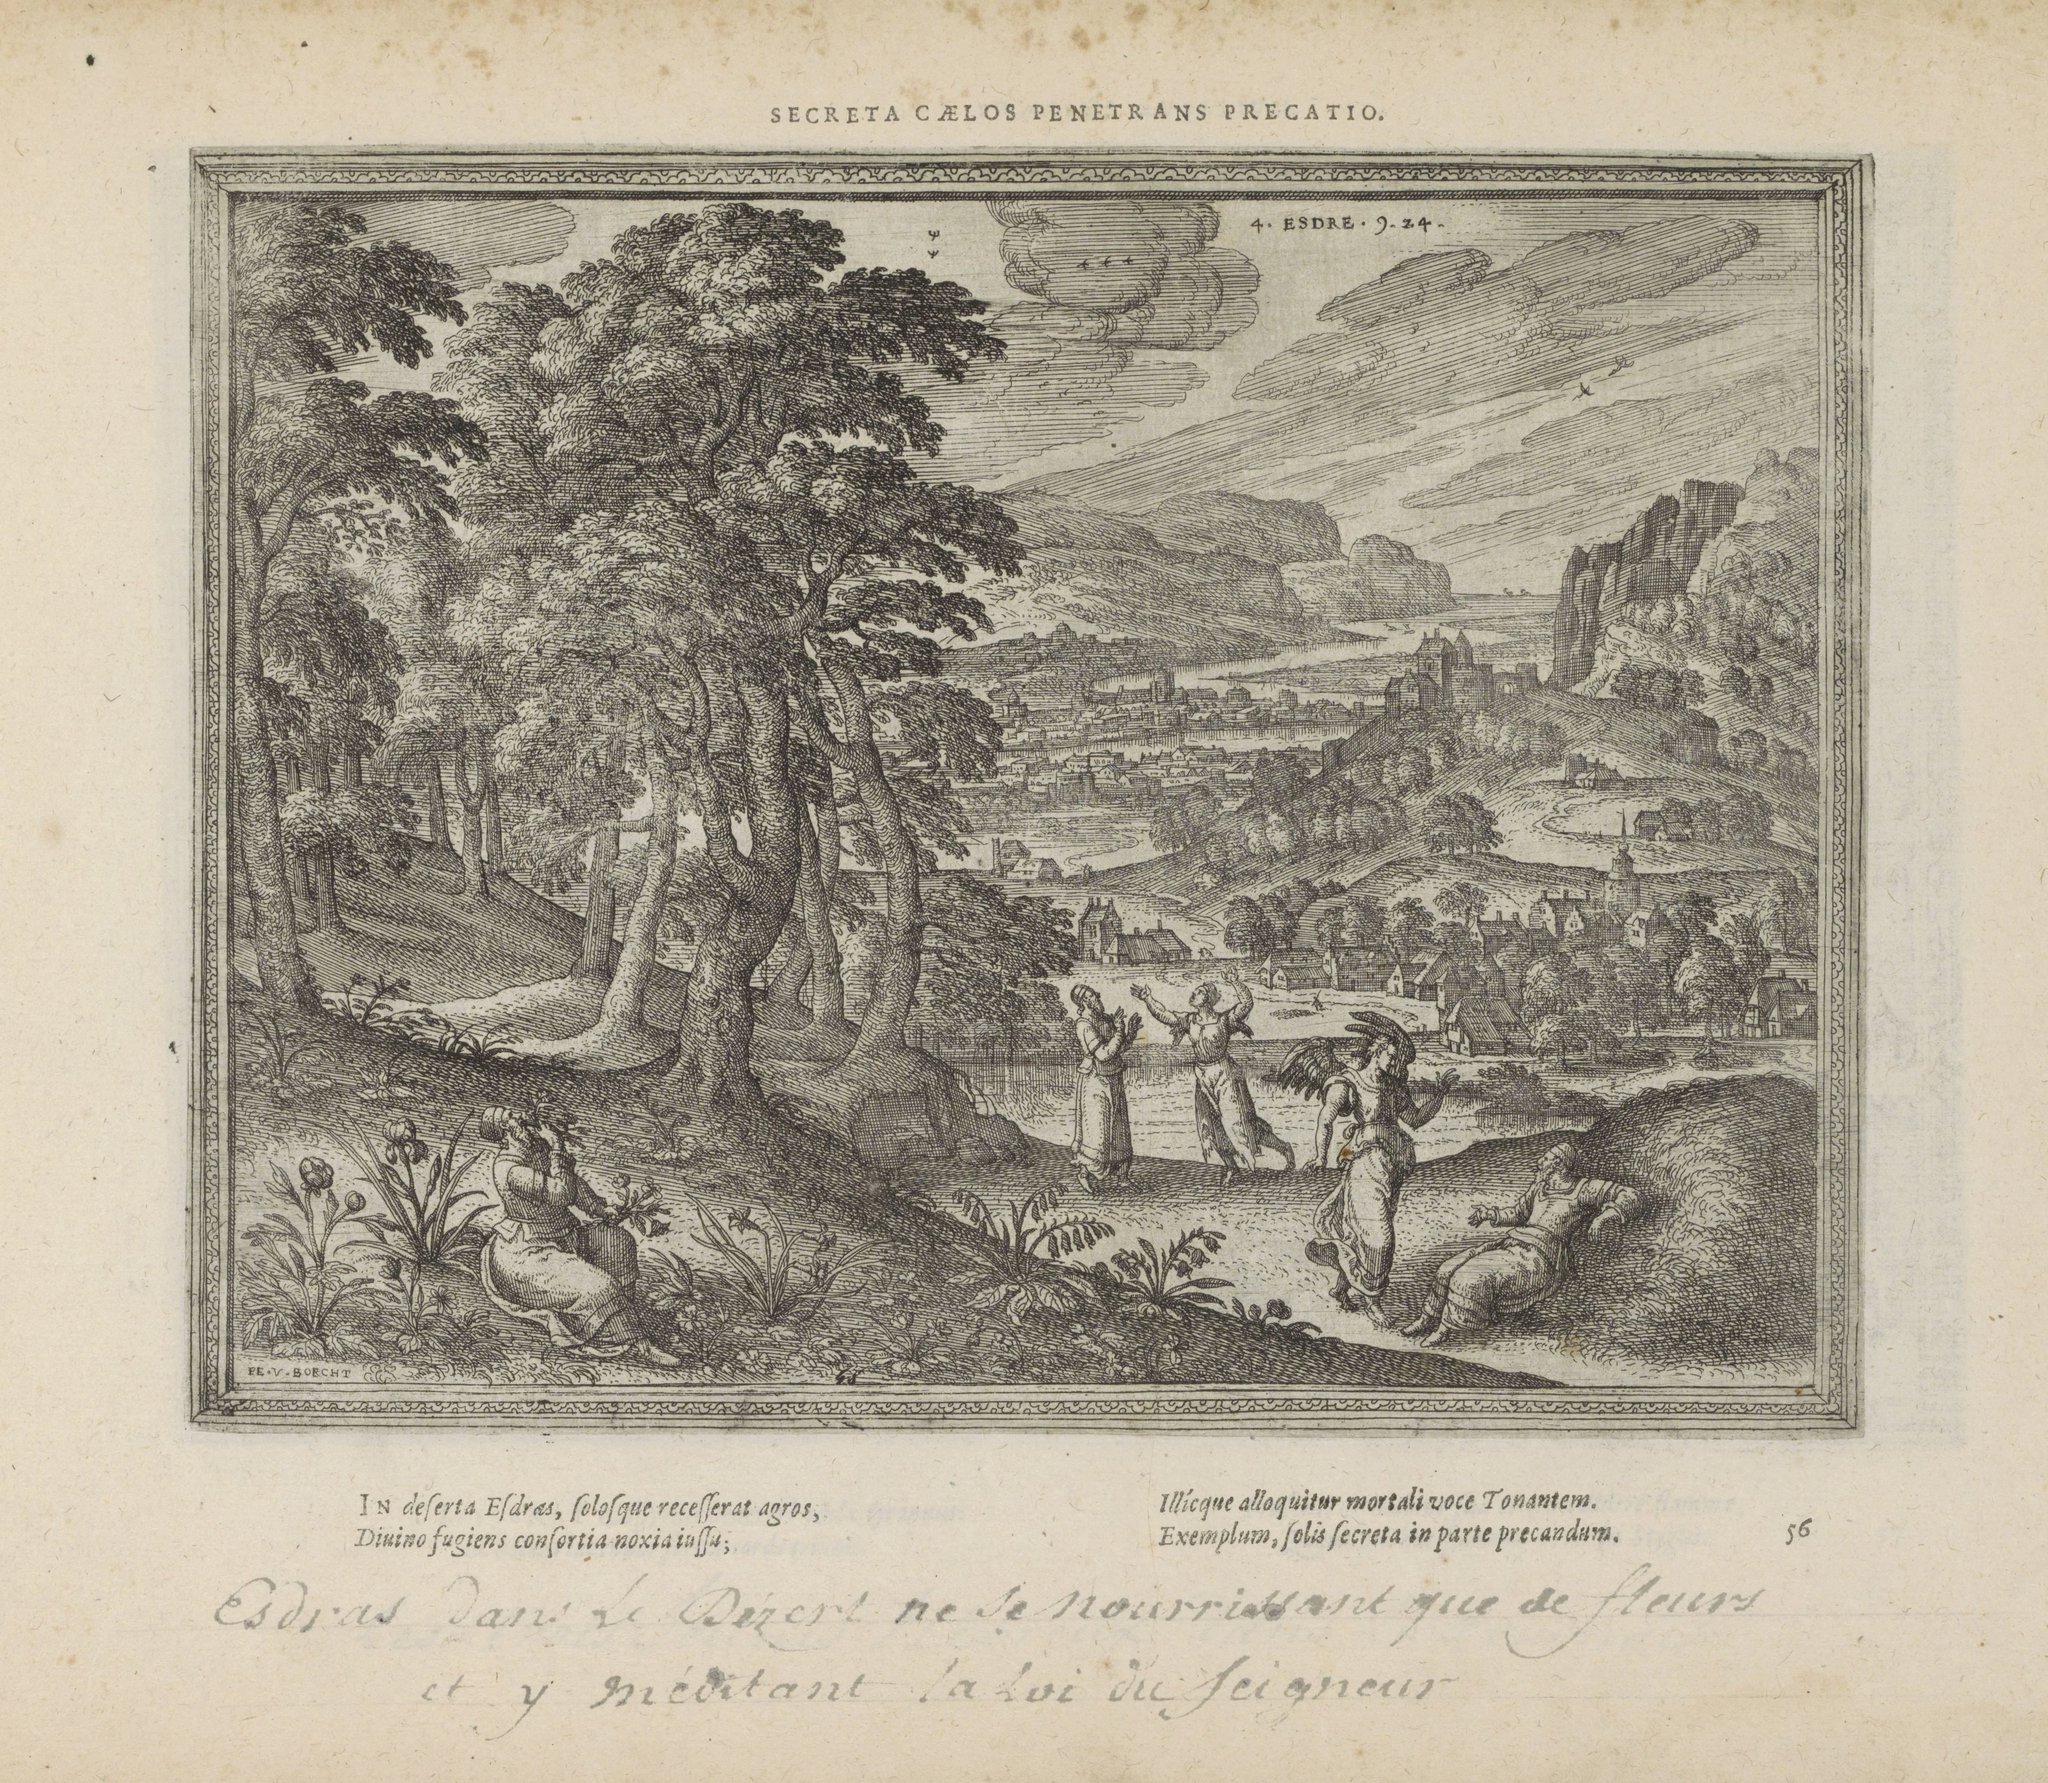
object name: album leaf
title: Ezra eet van de bloemen in het veld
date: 1582-1593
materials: paper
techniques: etching, letterpress printing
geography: amsterdam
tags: other scenes from ezra and esdras, landscapes with waters, waterscapes, seascapes (in the temperate zone), ezra and the archangel uriel (2 esdras 4:1)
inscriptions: inscription: ‘Esdras dans le desert ne se nourrissant que de fleurs et y méditant la loi du seigneur’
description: Heuvellandschap met links Ezra die eet van de bloemen in het veld. Aan de waterkant staat Ezra bij een treurende vrouw met gescheurde kleren. Daarnaast Ezra, liggend, en de engel Uriel. Met een motto in het Latijn boven de voorstelling en een vierregelig onderschrift in het Latijn onder de prent. De prent maakt deel uit van een album.